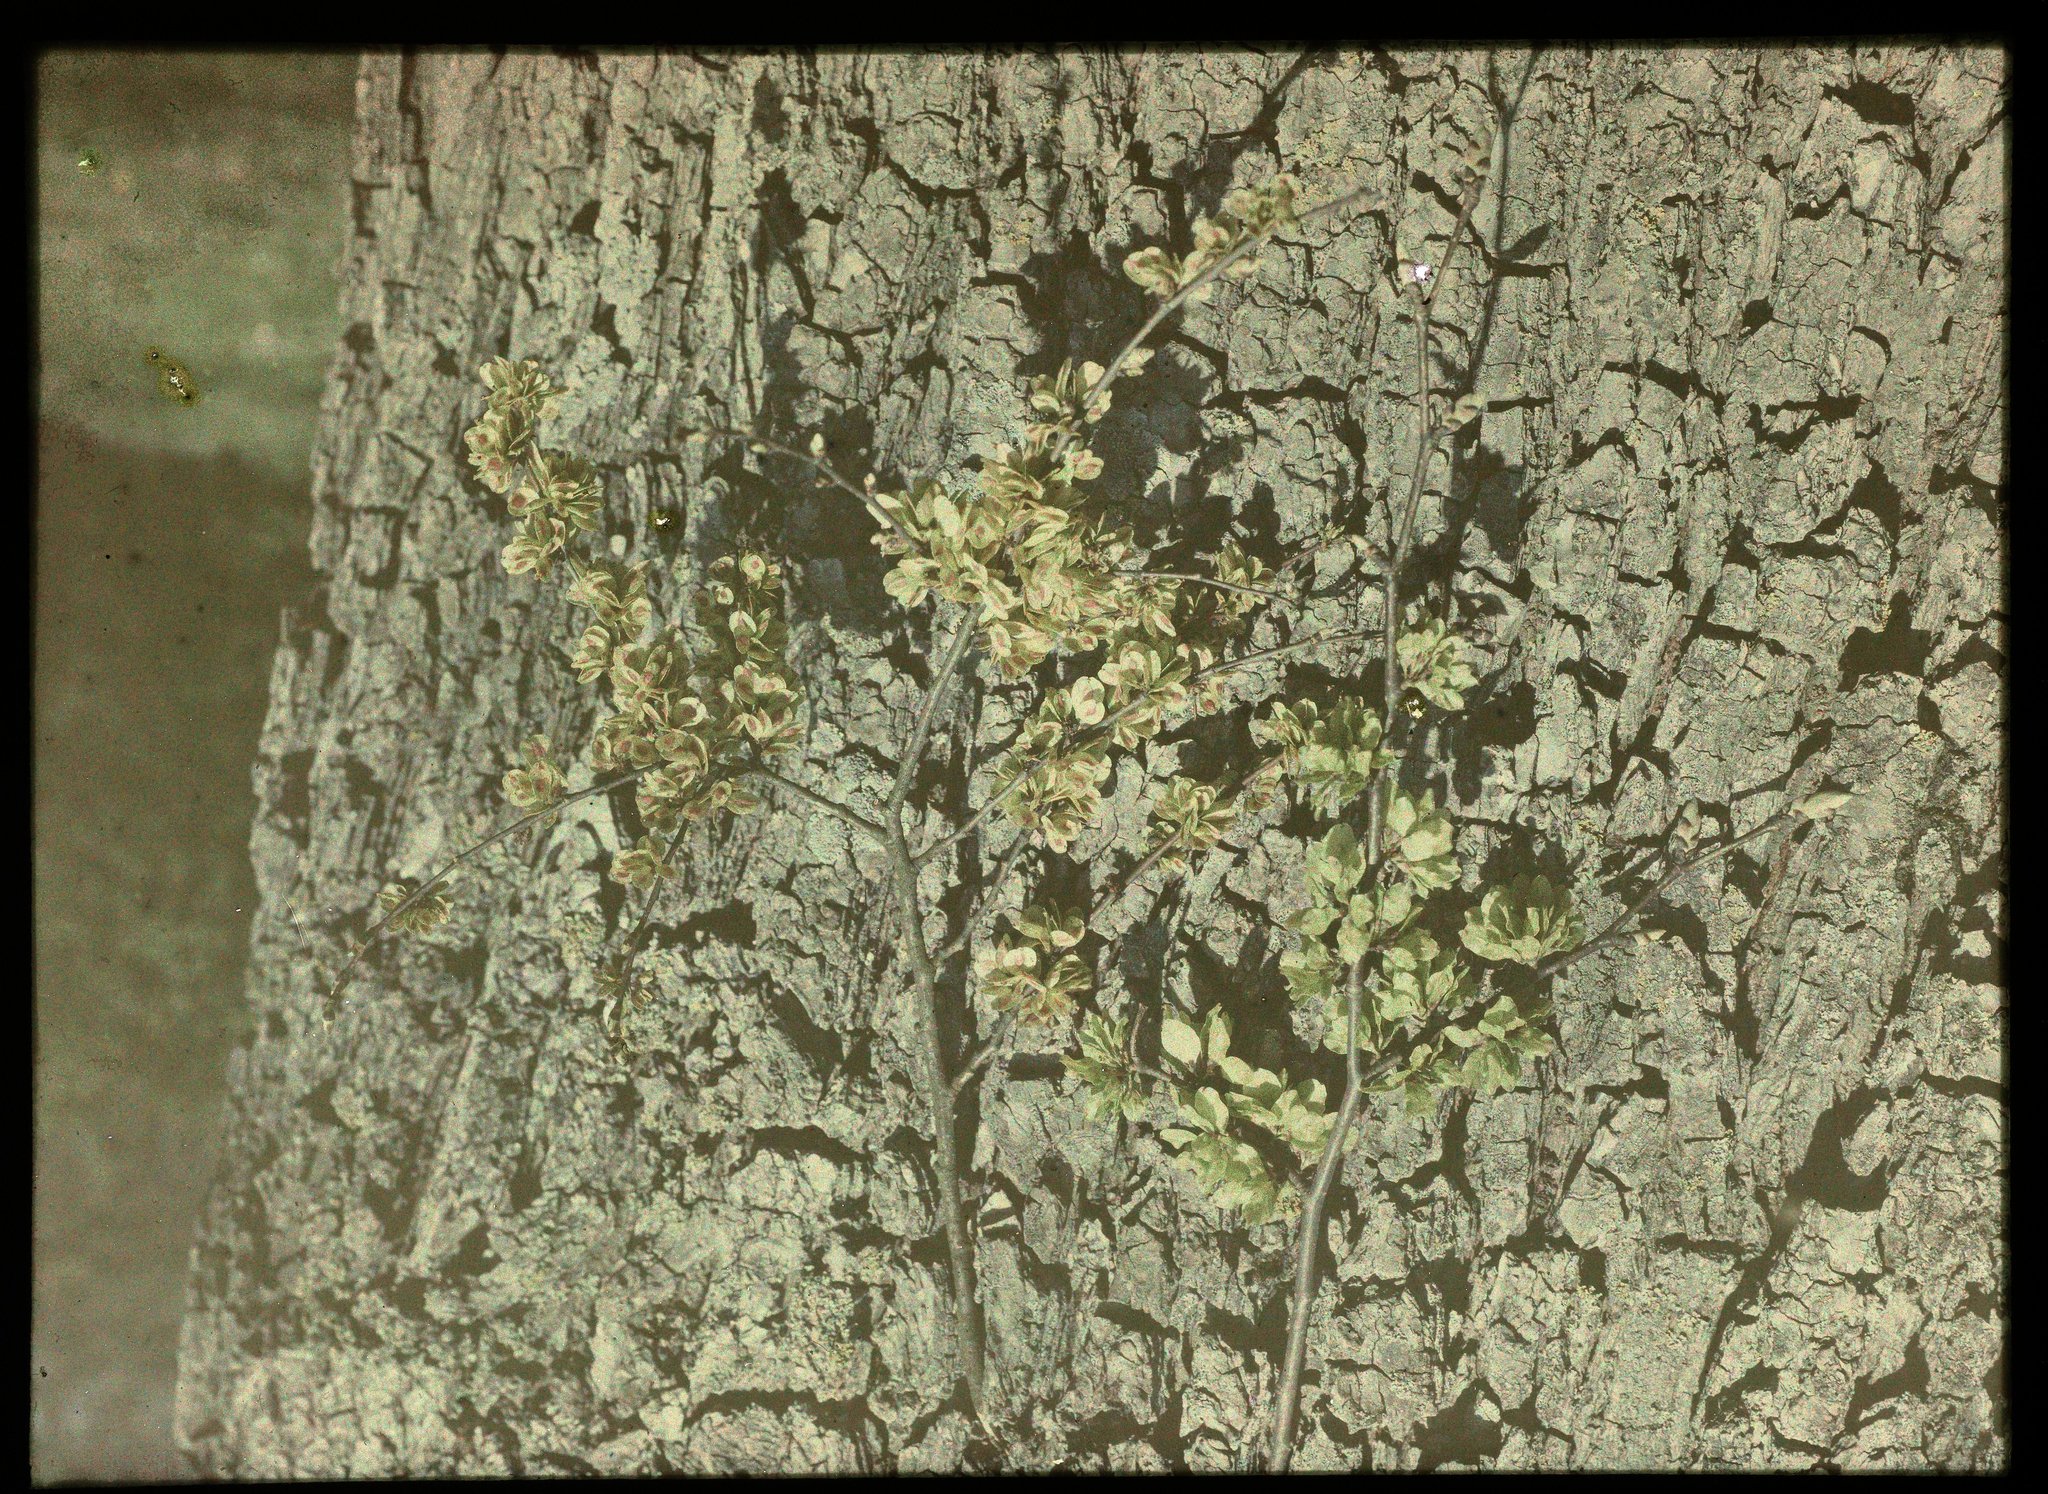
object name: photograph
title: Tak met katjes (?) tegen de schors van een boom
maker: adolphe burdet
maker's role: fotograaf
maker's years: 1860-1940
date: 1907-1930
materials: glass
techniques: autochrome process, slide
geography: netherlands